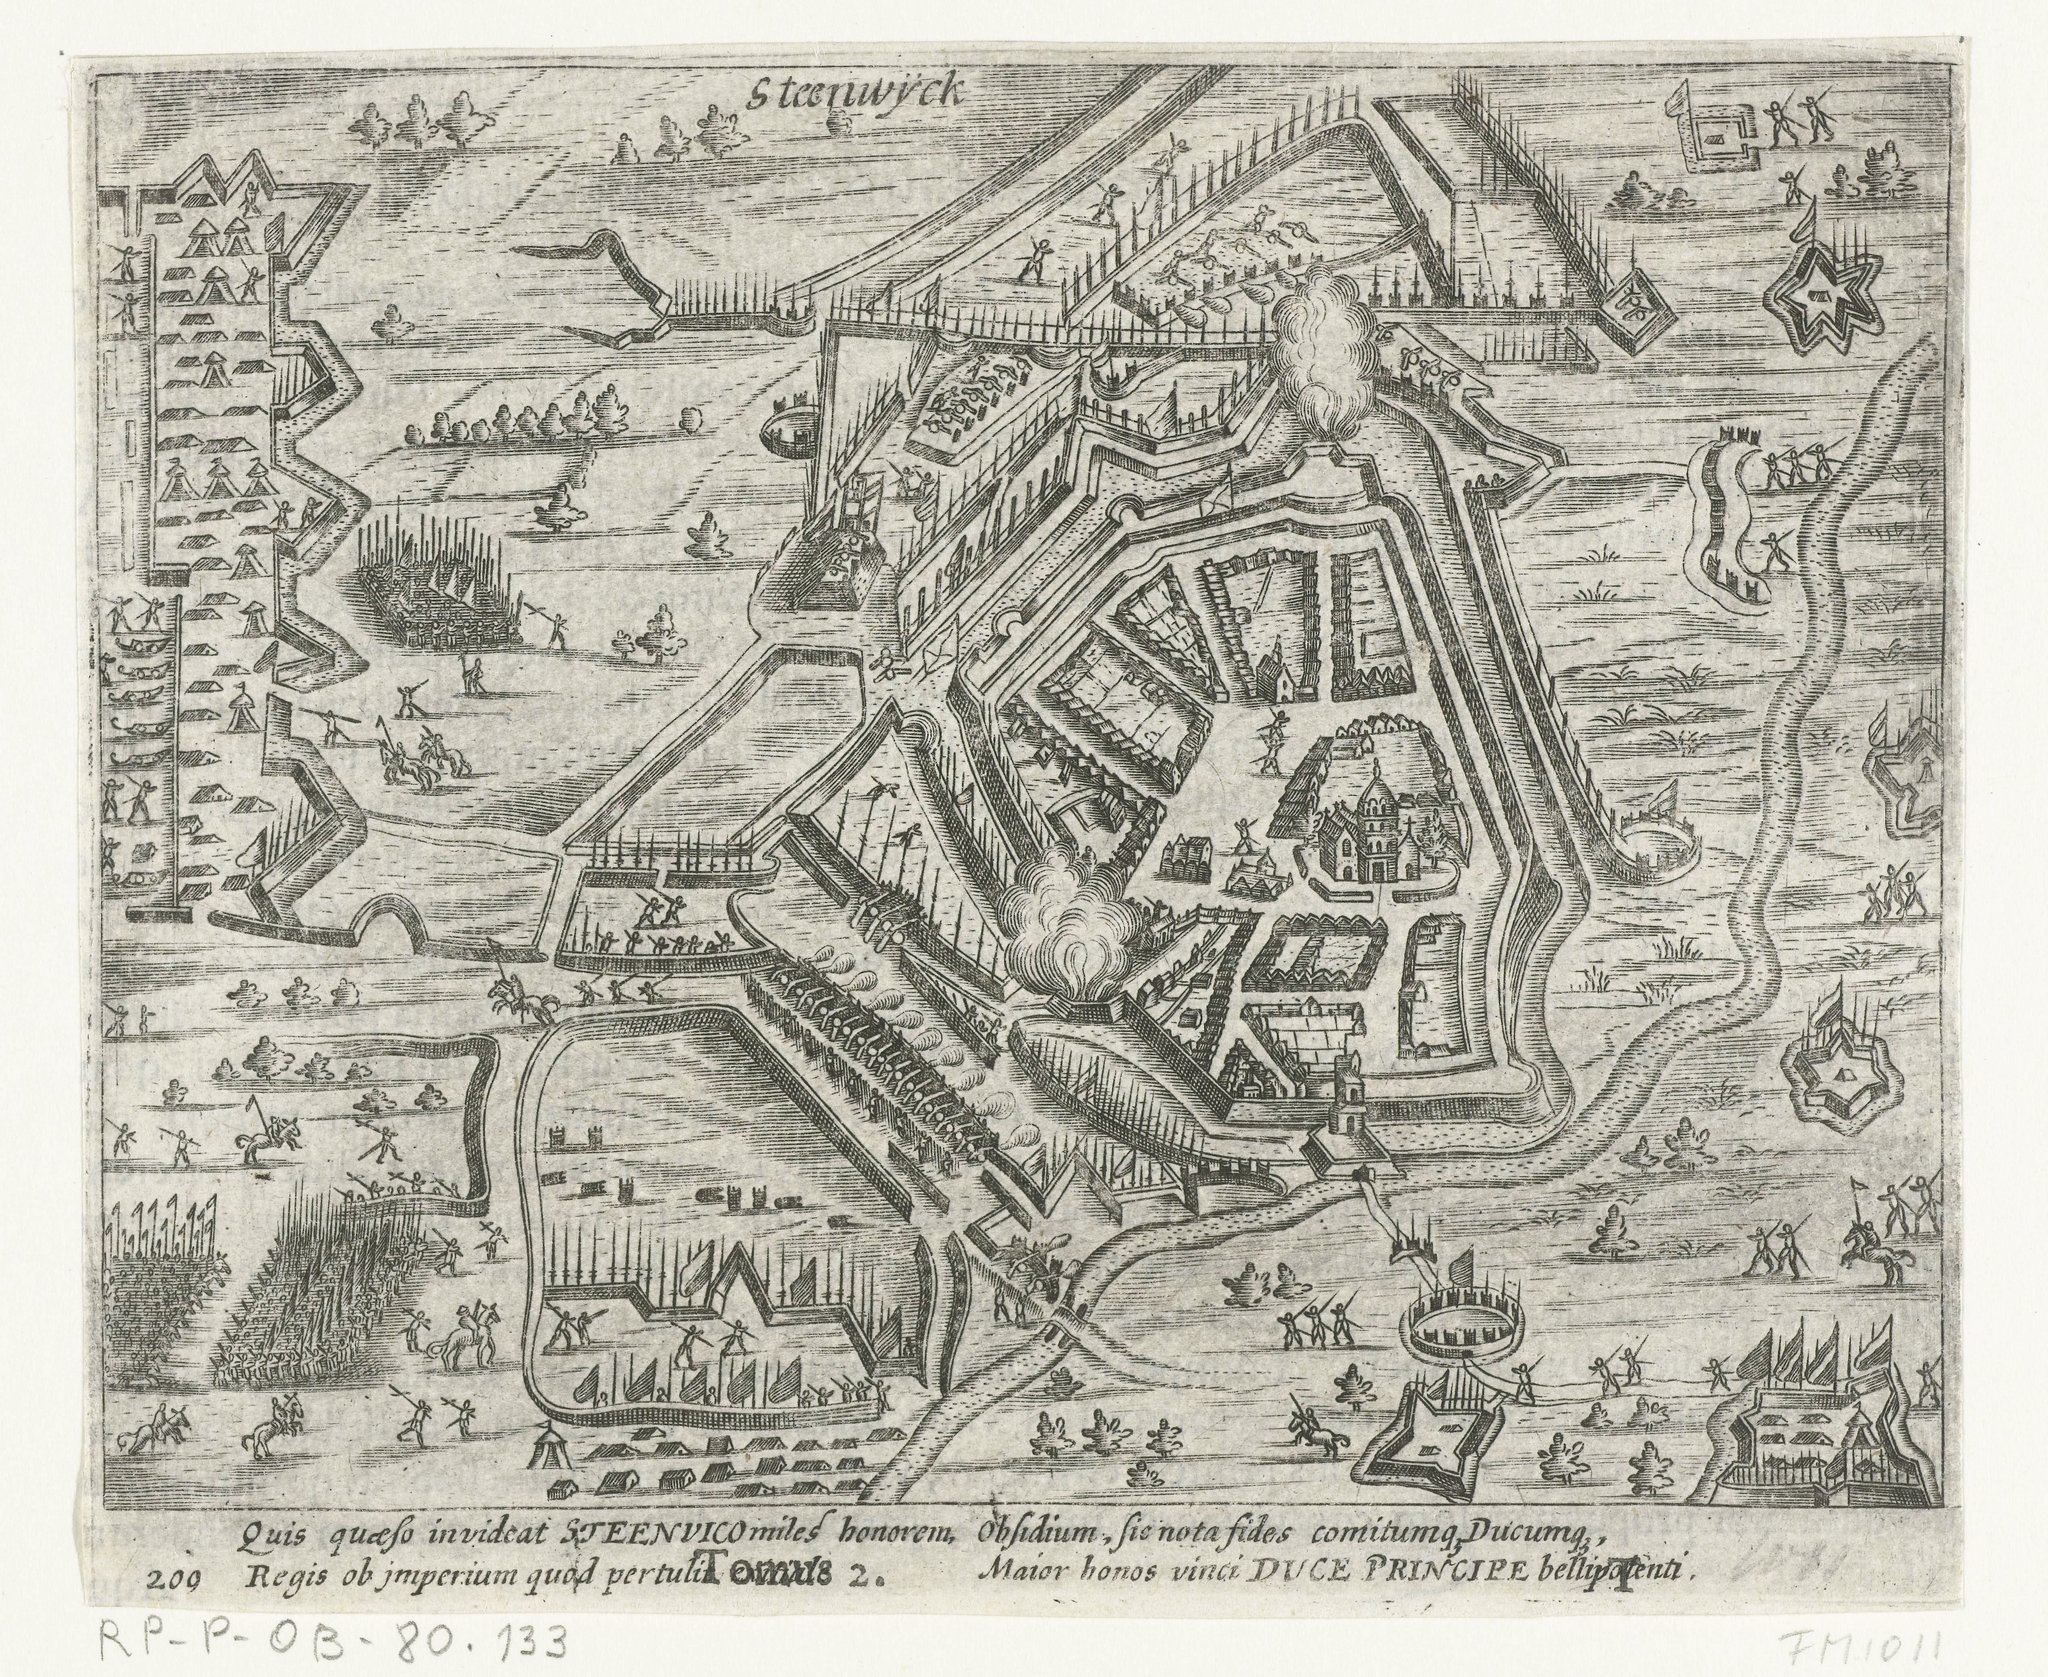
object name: history print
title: Beleg van Steenwijk, 1592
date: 1613-1615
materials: paper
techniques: engraving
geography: northern netherlands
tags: the hague, maurice (prince of orange), siege, position war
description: Beleg van Steenwijk door het Staatse leger onder Maurits, mei - juli 1592. Plan van Steenwijk en het omringende land met de posities van de belegerende troepen. Bij de stadmuren twee explosies. Met onderschrift van 4 regels in het Latijn. Genummerd 209. Bedrukt op achterzijde met tekst in het Latijn.